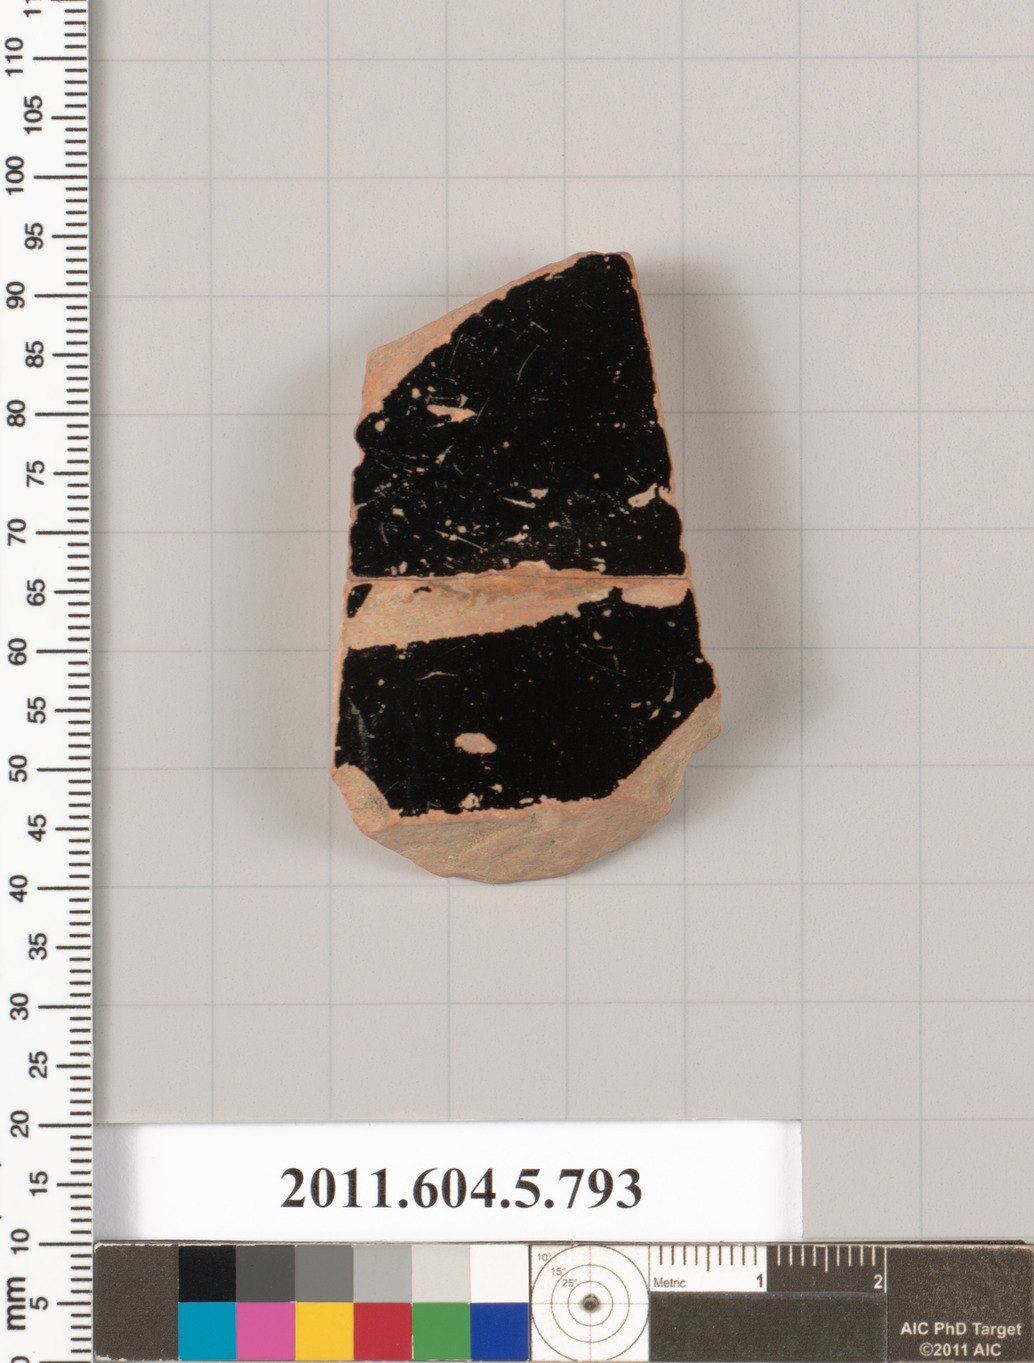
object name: kylix fragment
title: Terracotta fragment of a kylix (drinking cup)?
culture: greek, attic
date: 600-401 BCE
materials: terracotta